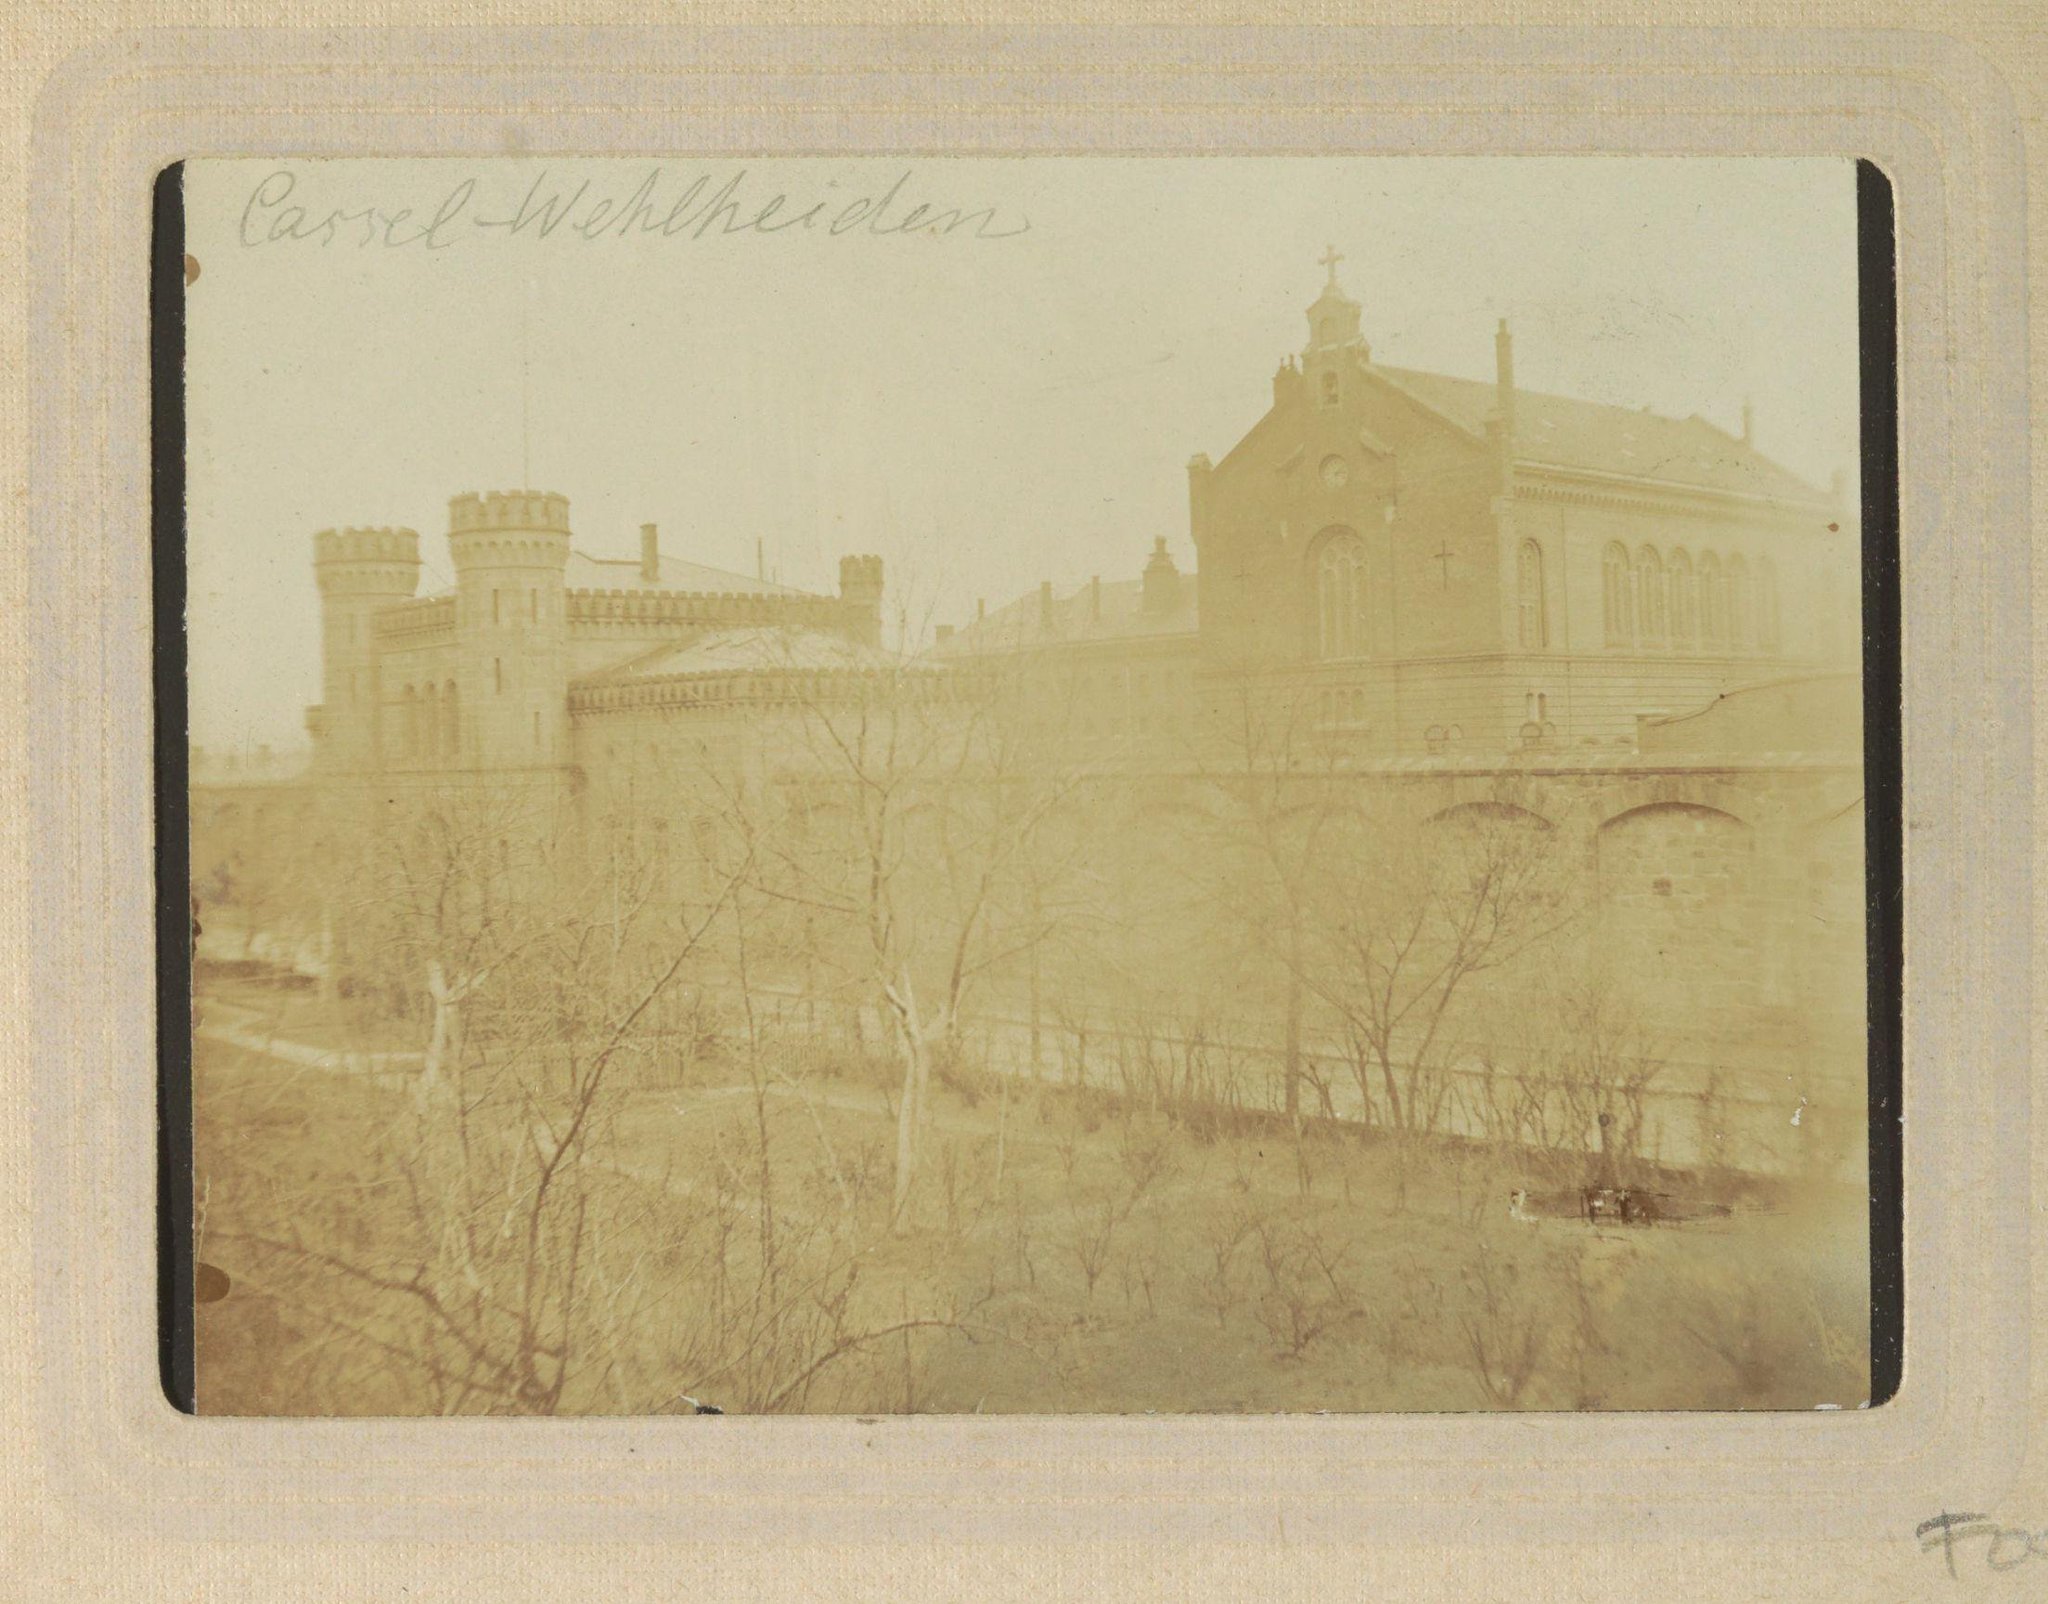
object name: photograph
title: Exterieur van de gevangenis in Cassel-Wehlheiden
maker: Anonymous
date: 1890-1910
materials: cardboard, paper, photographic support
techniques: gelatin silver print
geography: kassel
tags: prison, jail, fence, wall, paling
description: Onderdeel van Fotoalbum van Carl Heinrich Fliegenschmidt, gevangenisdirecteur te Oslebshausen.